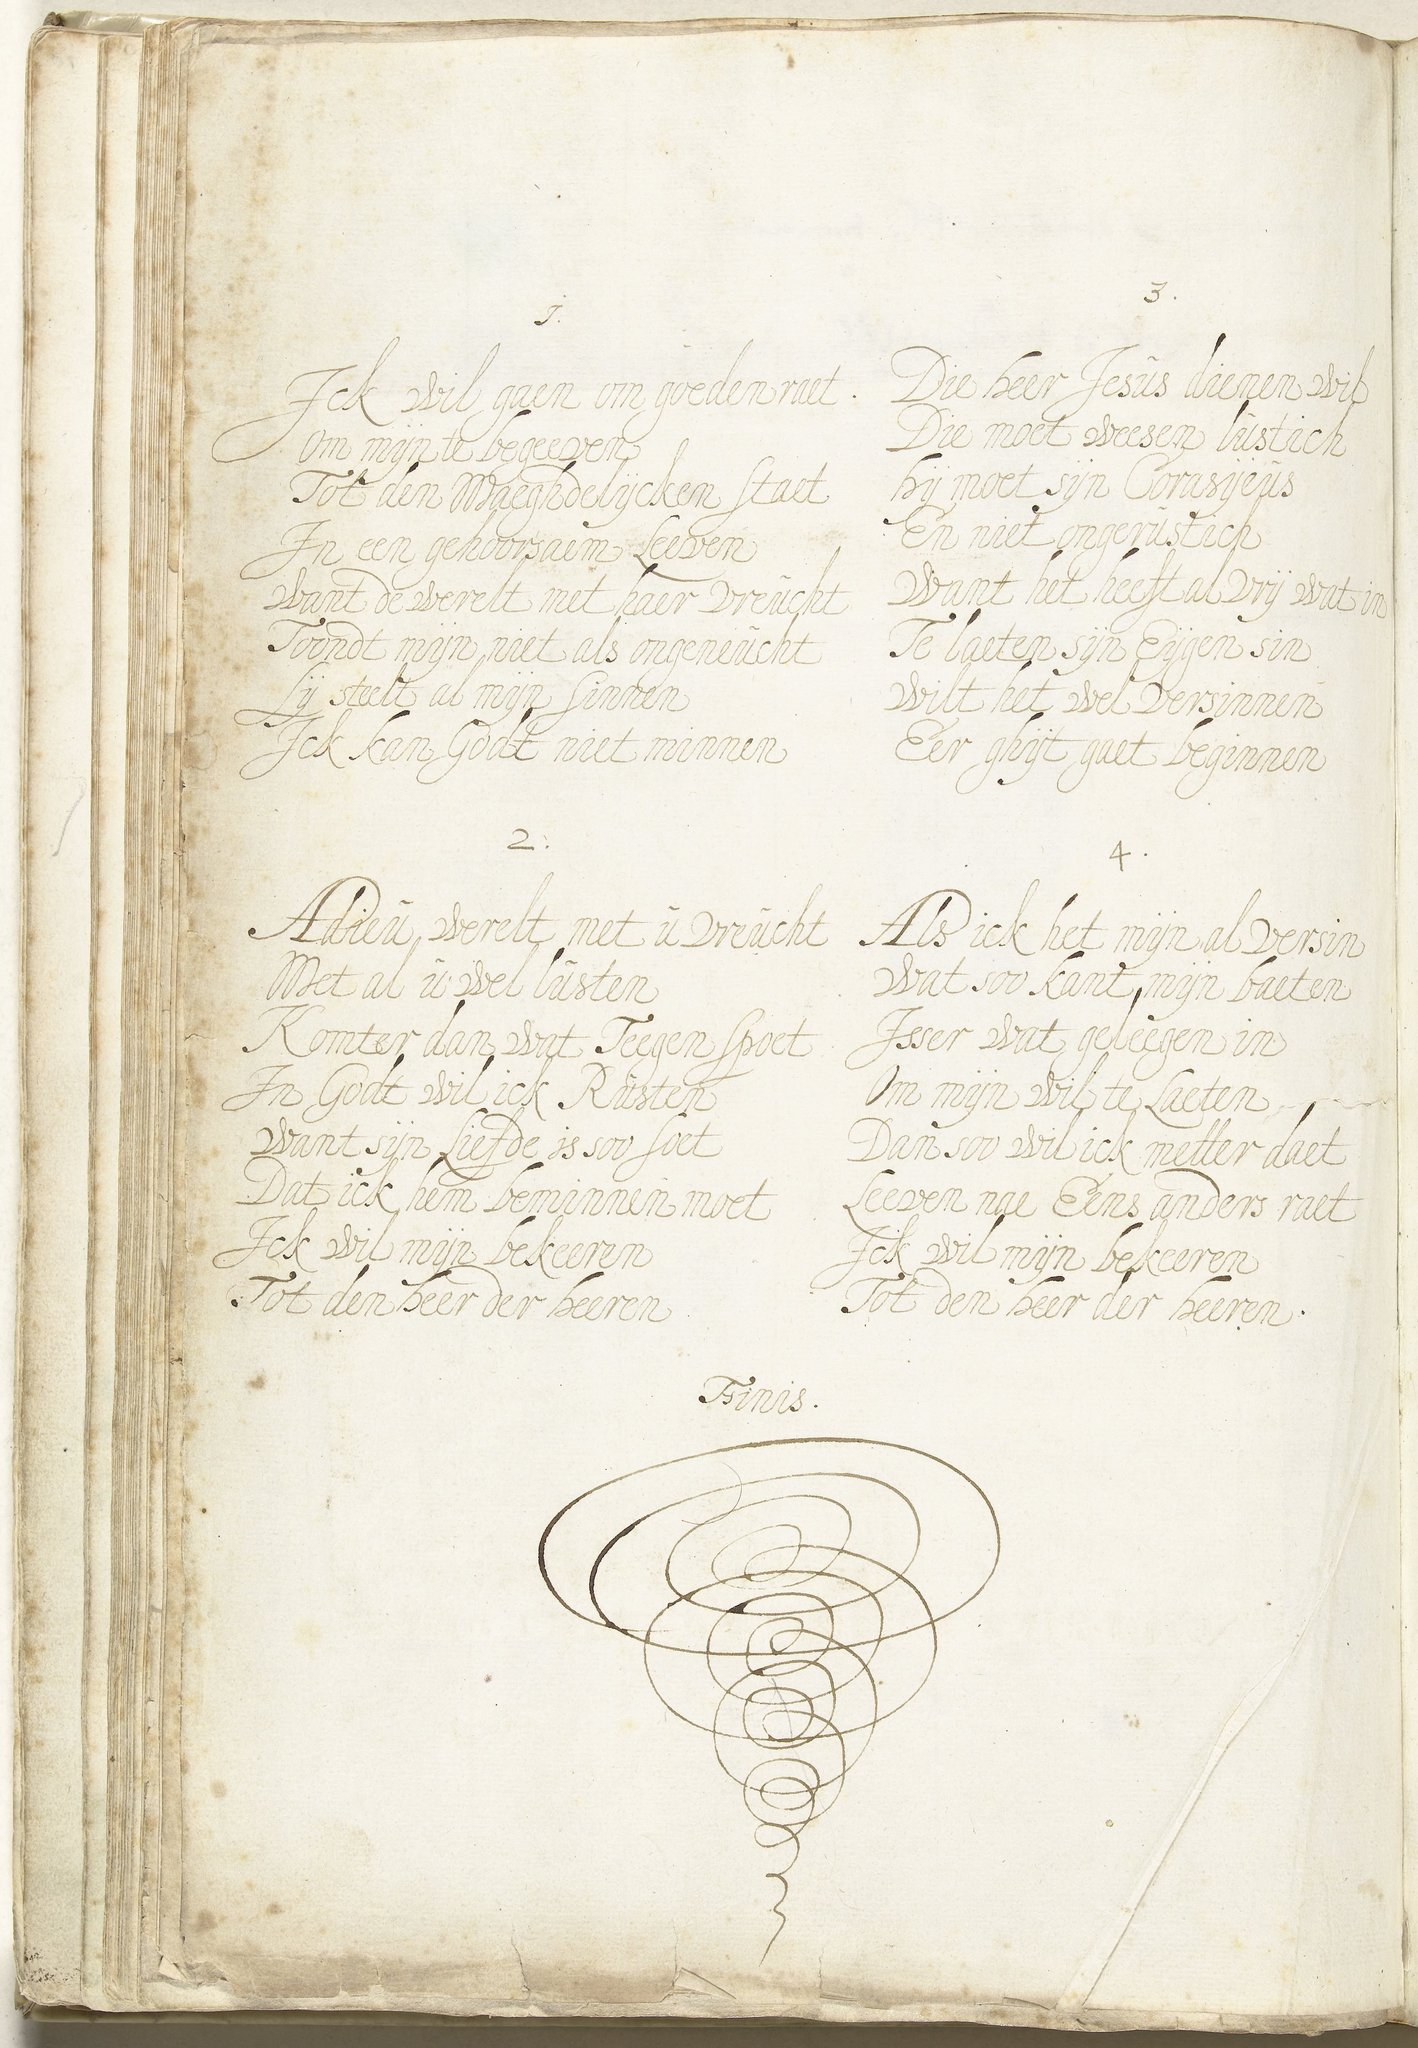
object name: calligraphy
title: Religieus gedicht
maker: gesina ter borch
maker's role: draughtsman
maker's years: 1633-1690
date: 1657-1659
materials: ink, paper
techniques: calligraphy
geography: zwolle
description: Het gedicht is met de aangegeven wijs 'Wat een vent is Hendrick' opgenomen in 'Een nieuw zuyverlijk boeksken', een van de eerste Nederlandse religieuze liedboeken.